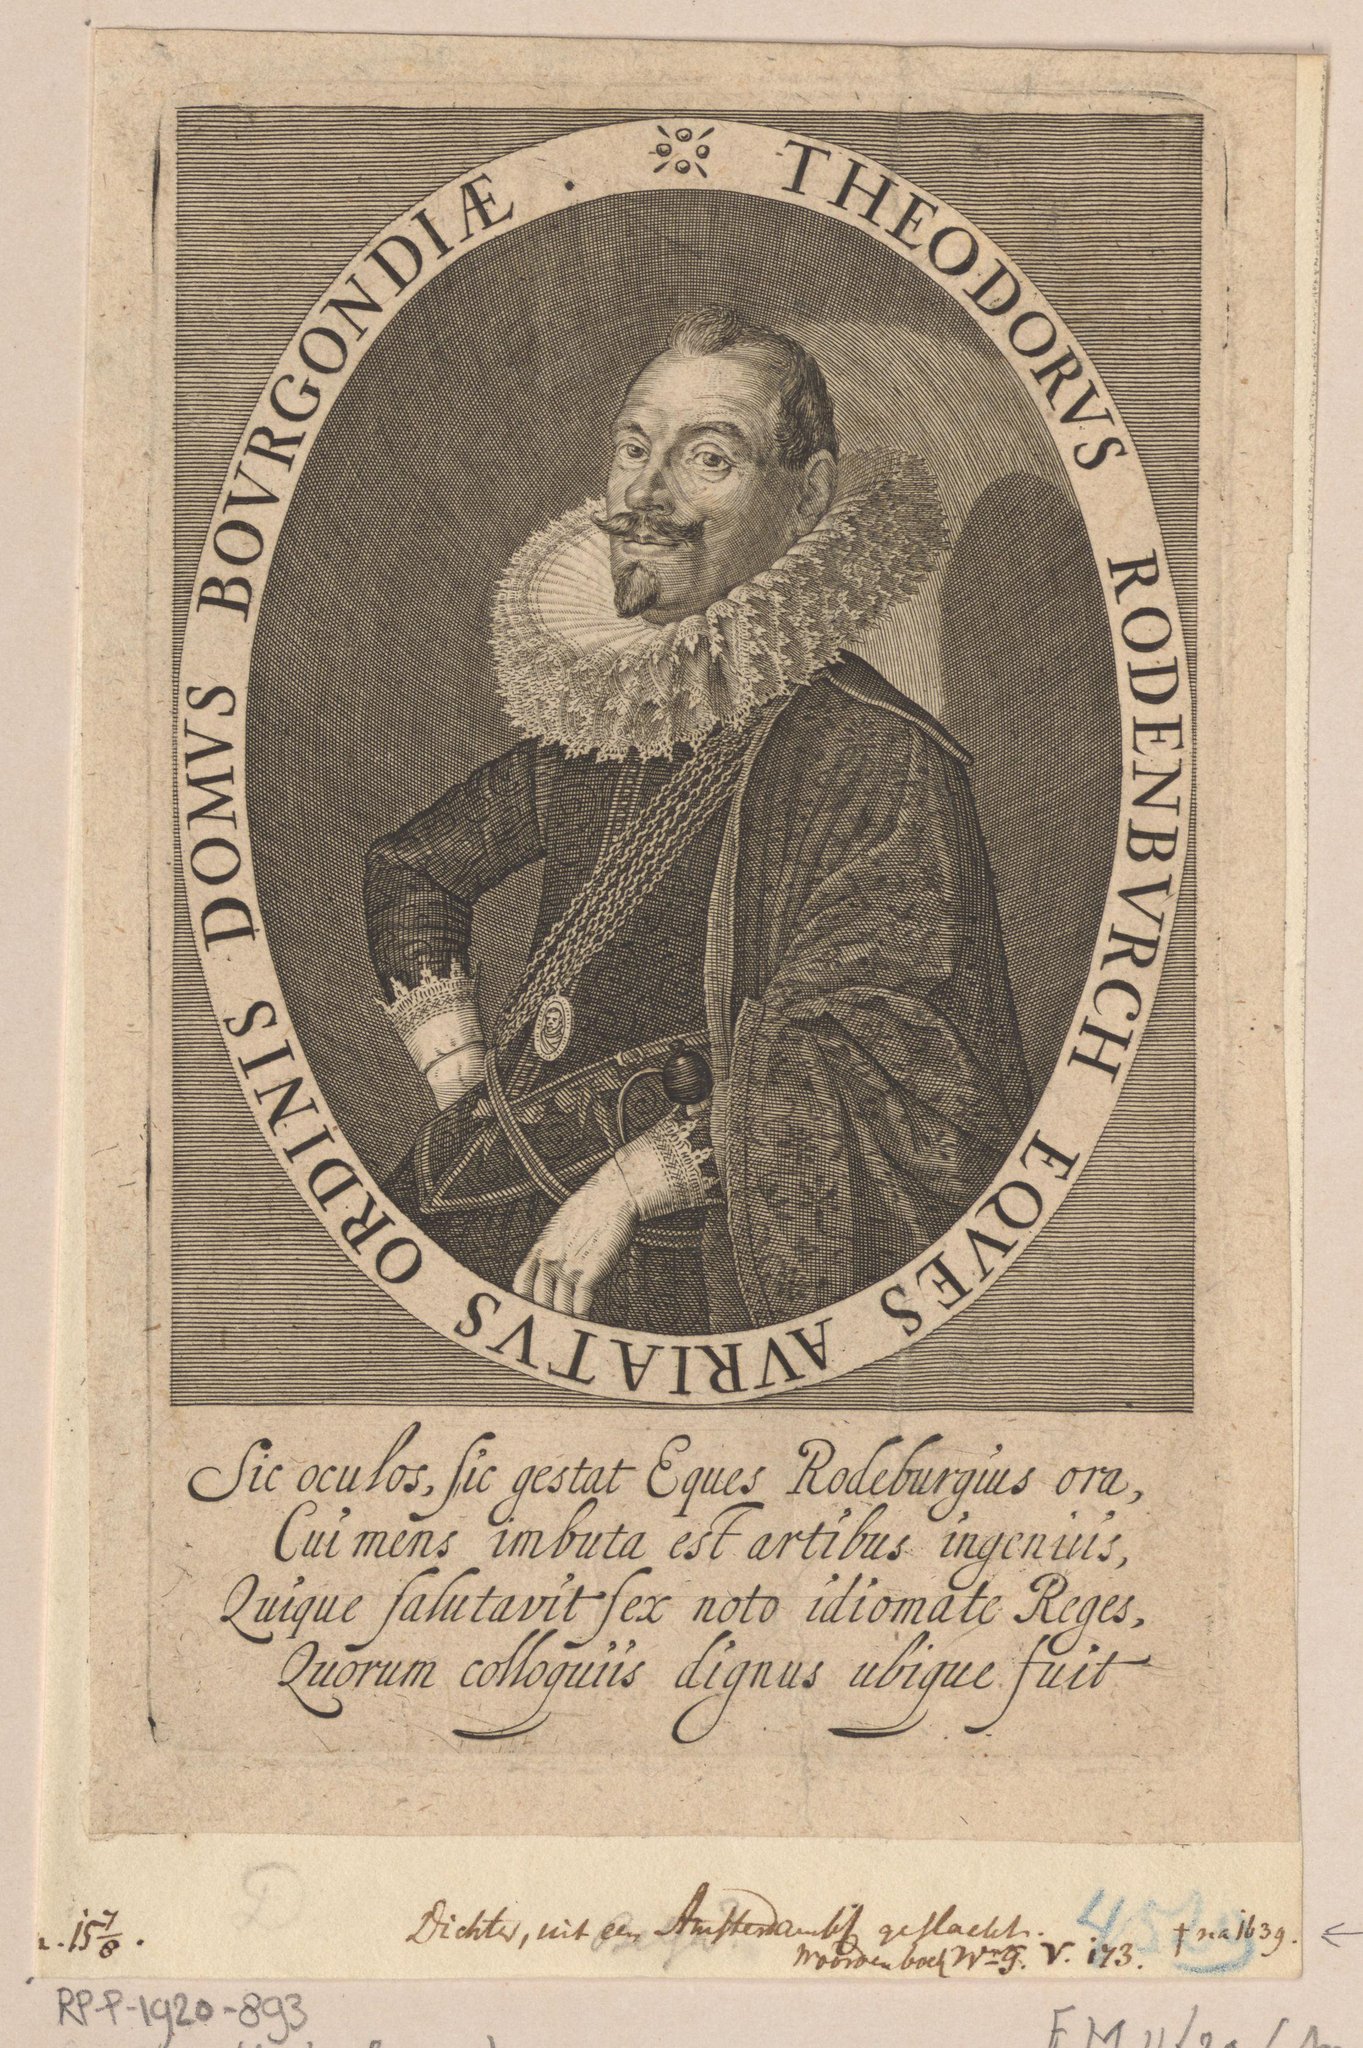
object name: print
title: Portret van Theodorus Rodenburg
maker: lucas kilian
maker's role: draughtsman, print maker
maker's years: 1579-1637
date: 1589-1637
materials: paper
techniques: engraving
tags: antwerp, theodorus rodenburg, historical persons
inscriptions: collector's mark: Lugt 2228